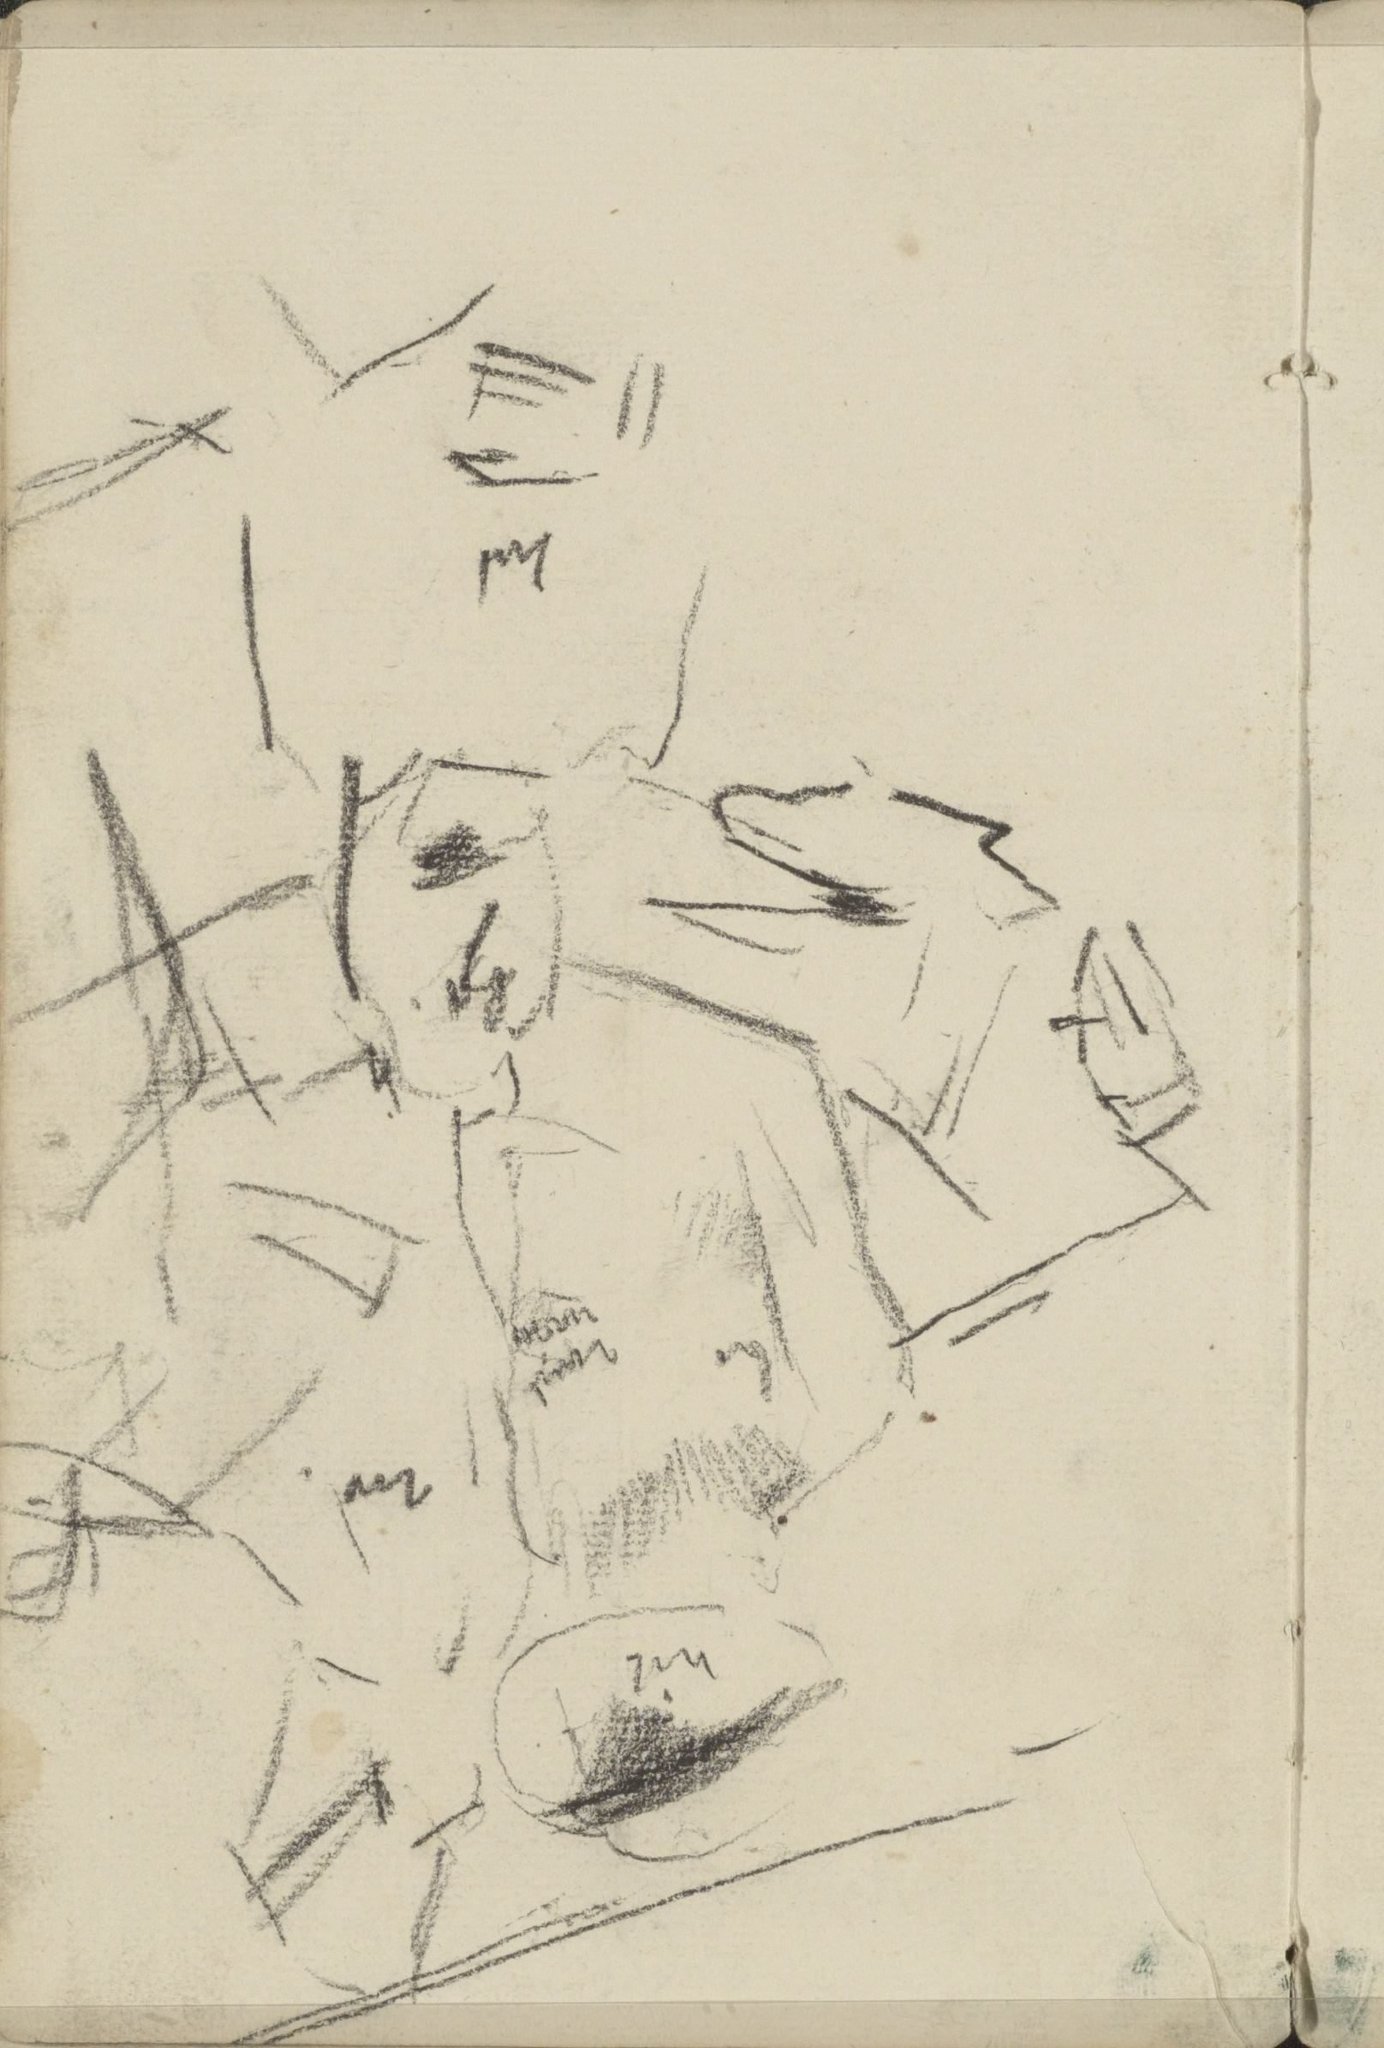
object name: sketchbook leaf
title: Figuren, mogelijk in een open rijtuig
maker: george hendrik breitner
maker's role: draughtsman, painter, print maker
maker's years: 1857-1923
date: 1886-1903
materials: chalk, paper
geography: amsterdam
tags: four-wheeled, animal-drawn vehicle, e.g.: cab, carriage, coach (+ two persons ~ traffic and transport)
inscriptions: kleurnotitie, handgeschreven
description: Pagina 9 uit een schetsboek met 15 bladen.